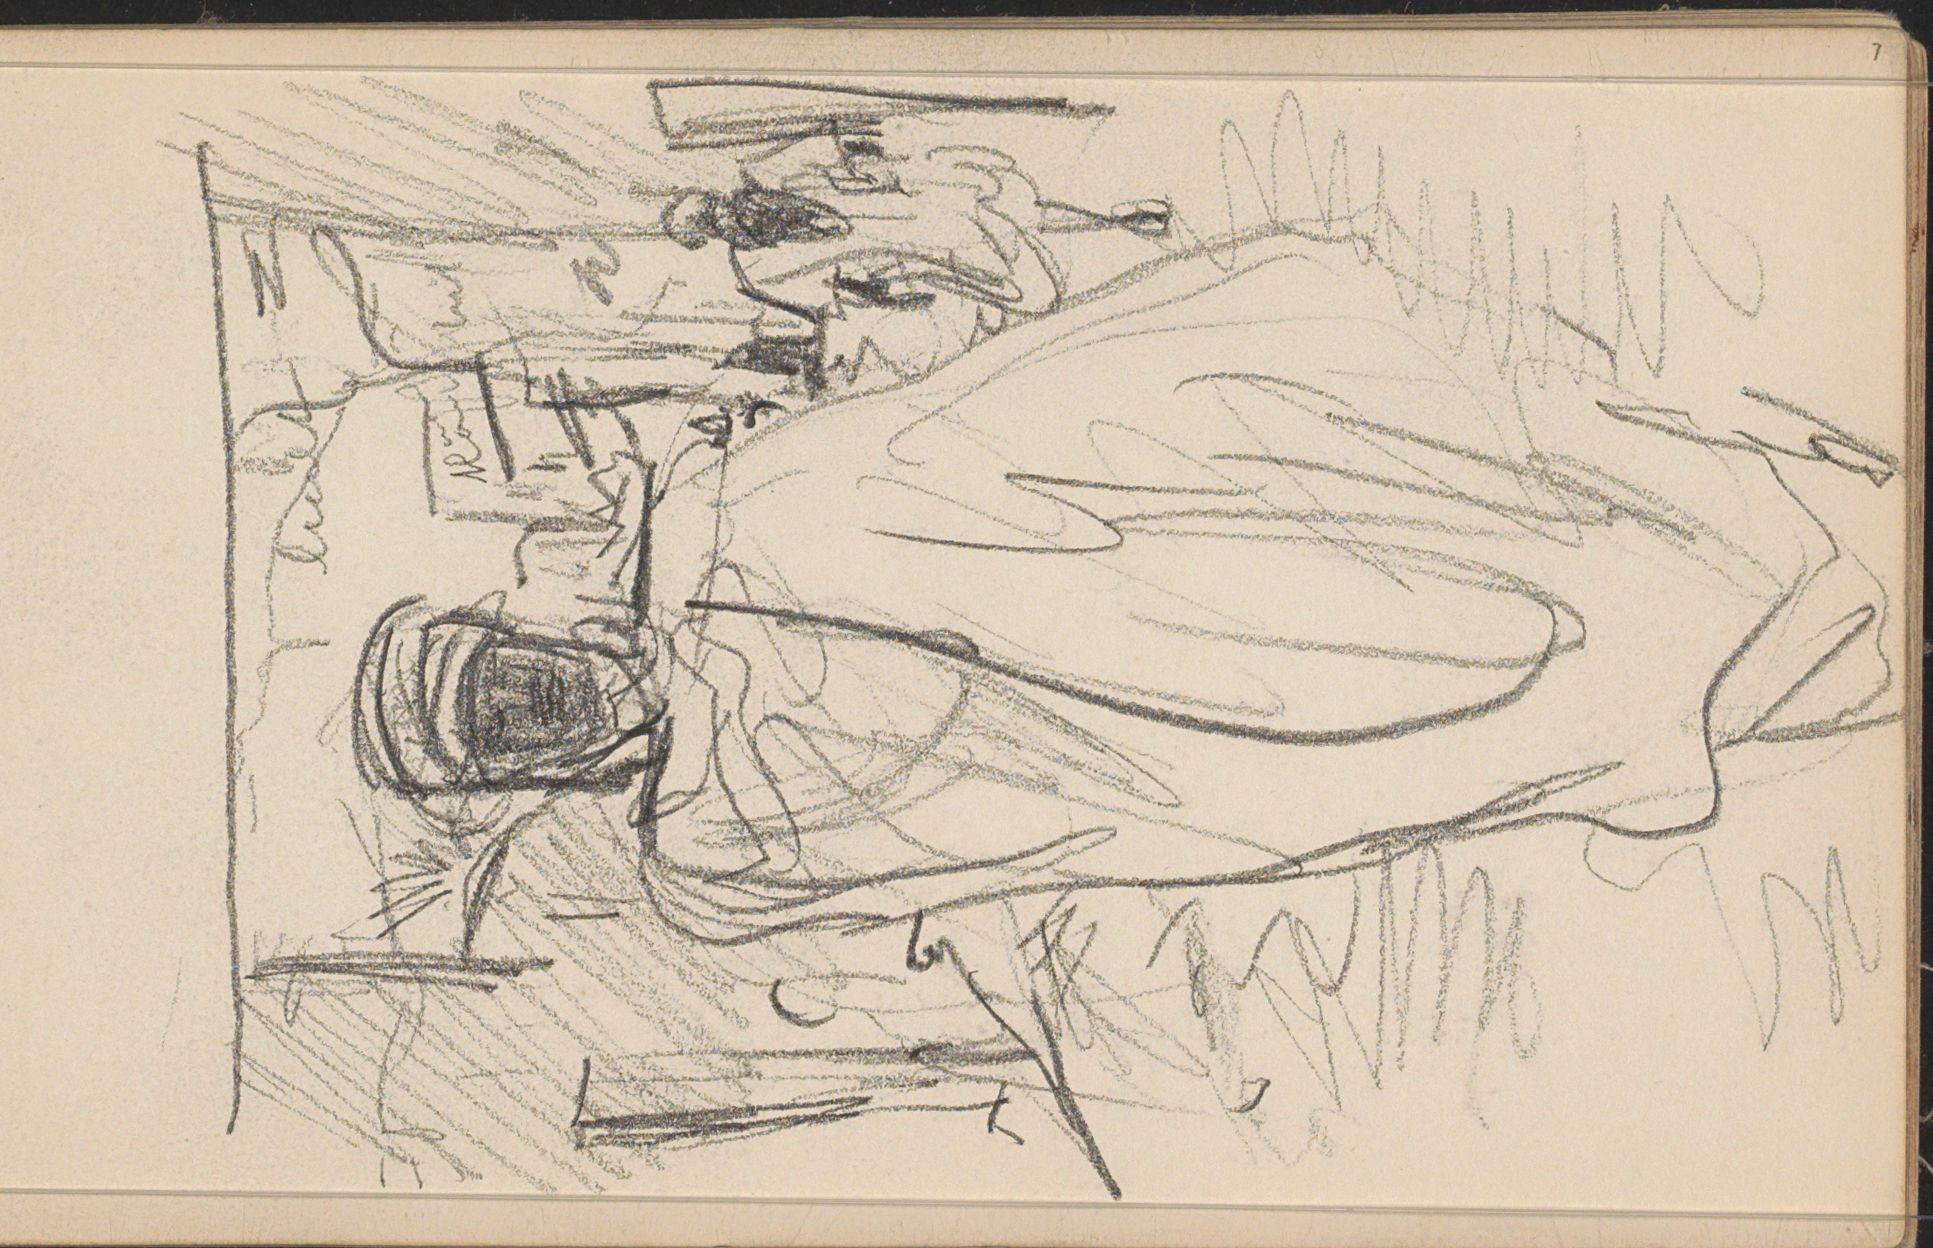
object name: sketchbook leaf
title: Straat met figuren in Biskra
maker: marius bauer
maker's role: draughtsman, print maker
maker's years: 1867-1932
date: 1922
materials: paper, pencil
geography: biskra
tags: africans, folk costume, regional costume, street (+ city(-scape) with figures, staffage)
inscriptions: kleurnotitie, handgeschreven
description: Op de voorgrond een Algerijn in traditioneel Noord-Afrikaans kostuum. Pagina 7 uit een schetsboek met 31 bladen.